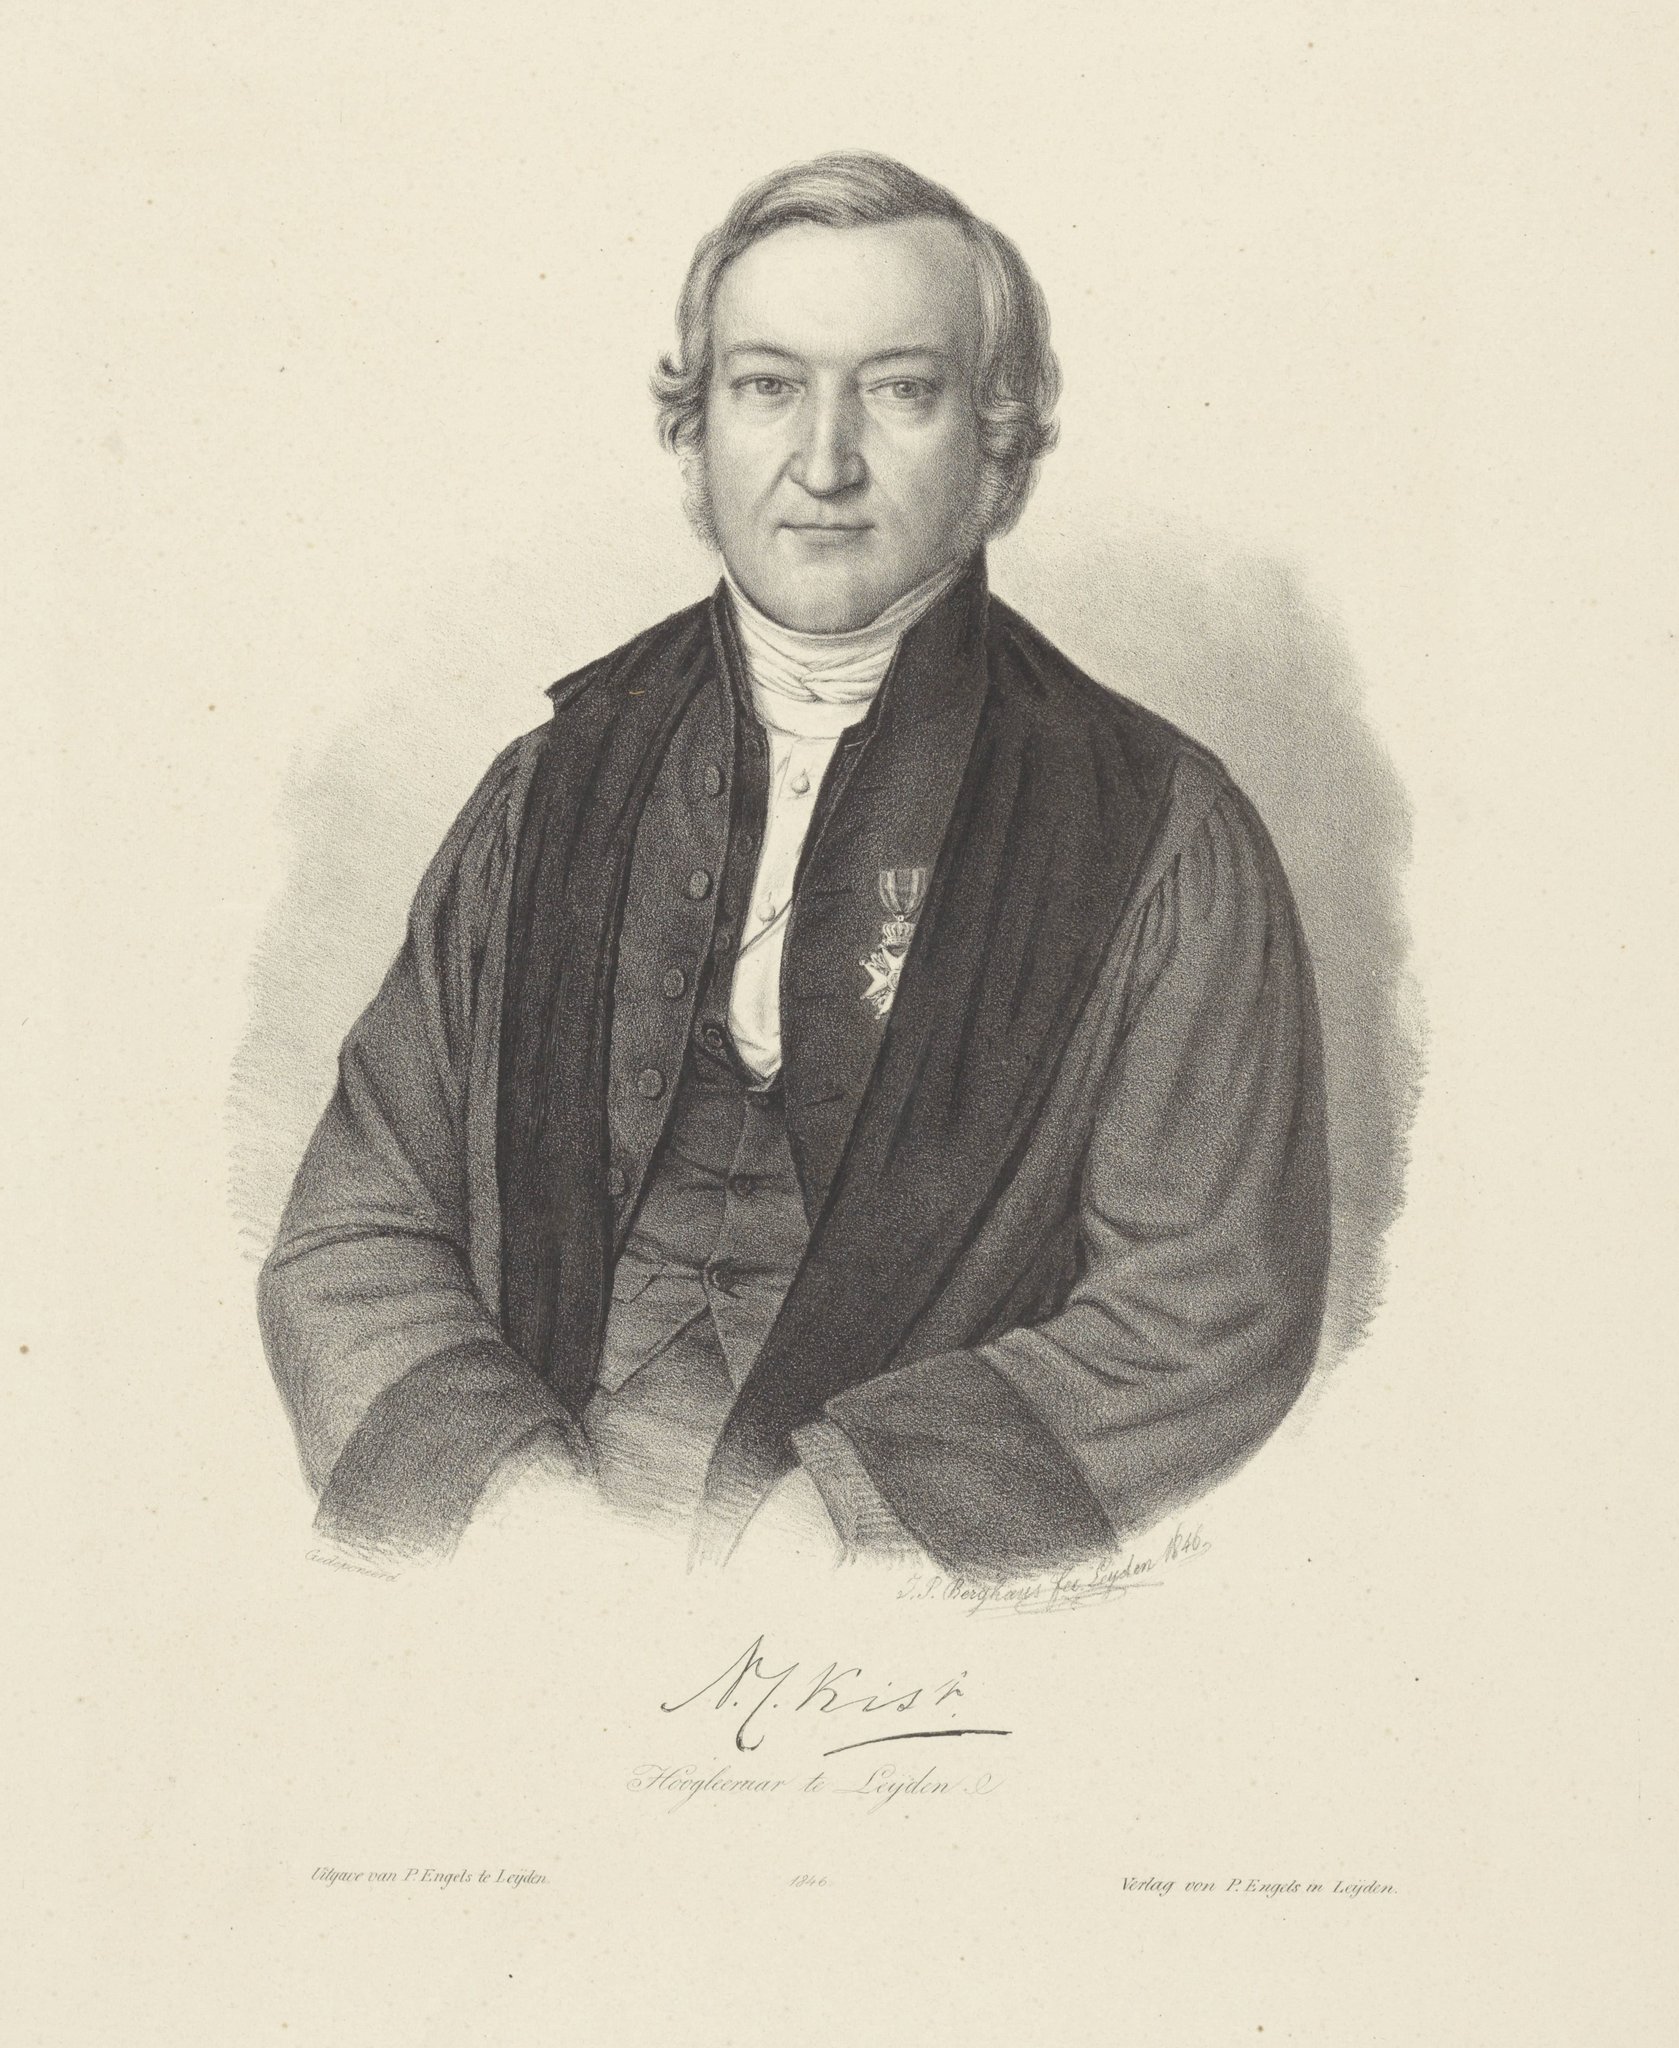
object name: print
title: Portret van Nicolaas Christiaan Kist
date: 1846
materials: paper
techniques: lithograph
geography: leiden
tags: knighthood order, historical persons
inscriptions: collector's mark: Lugt 2228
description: De geportretteerde draagt een toga en een ridderorde op zijn borst. Onder het portret zijn signatuur en beroep.